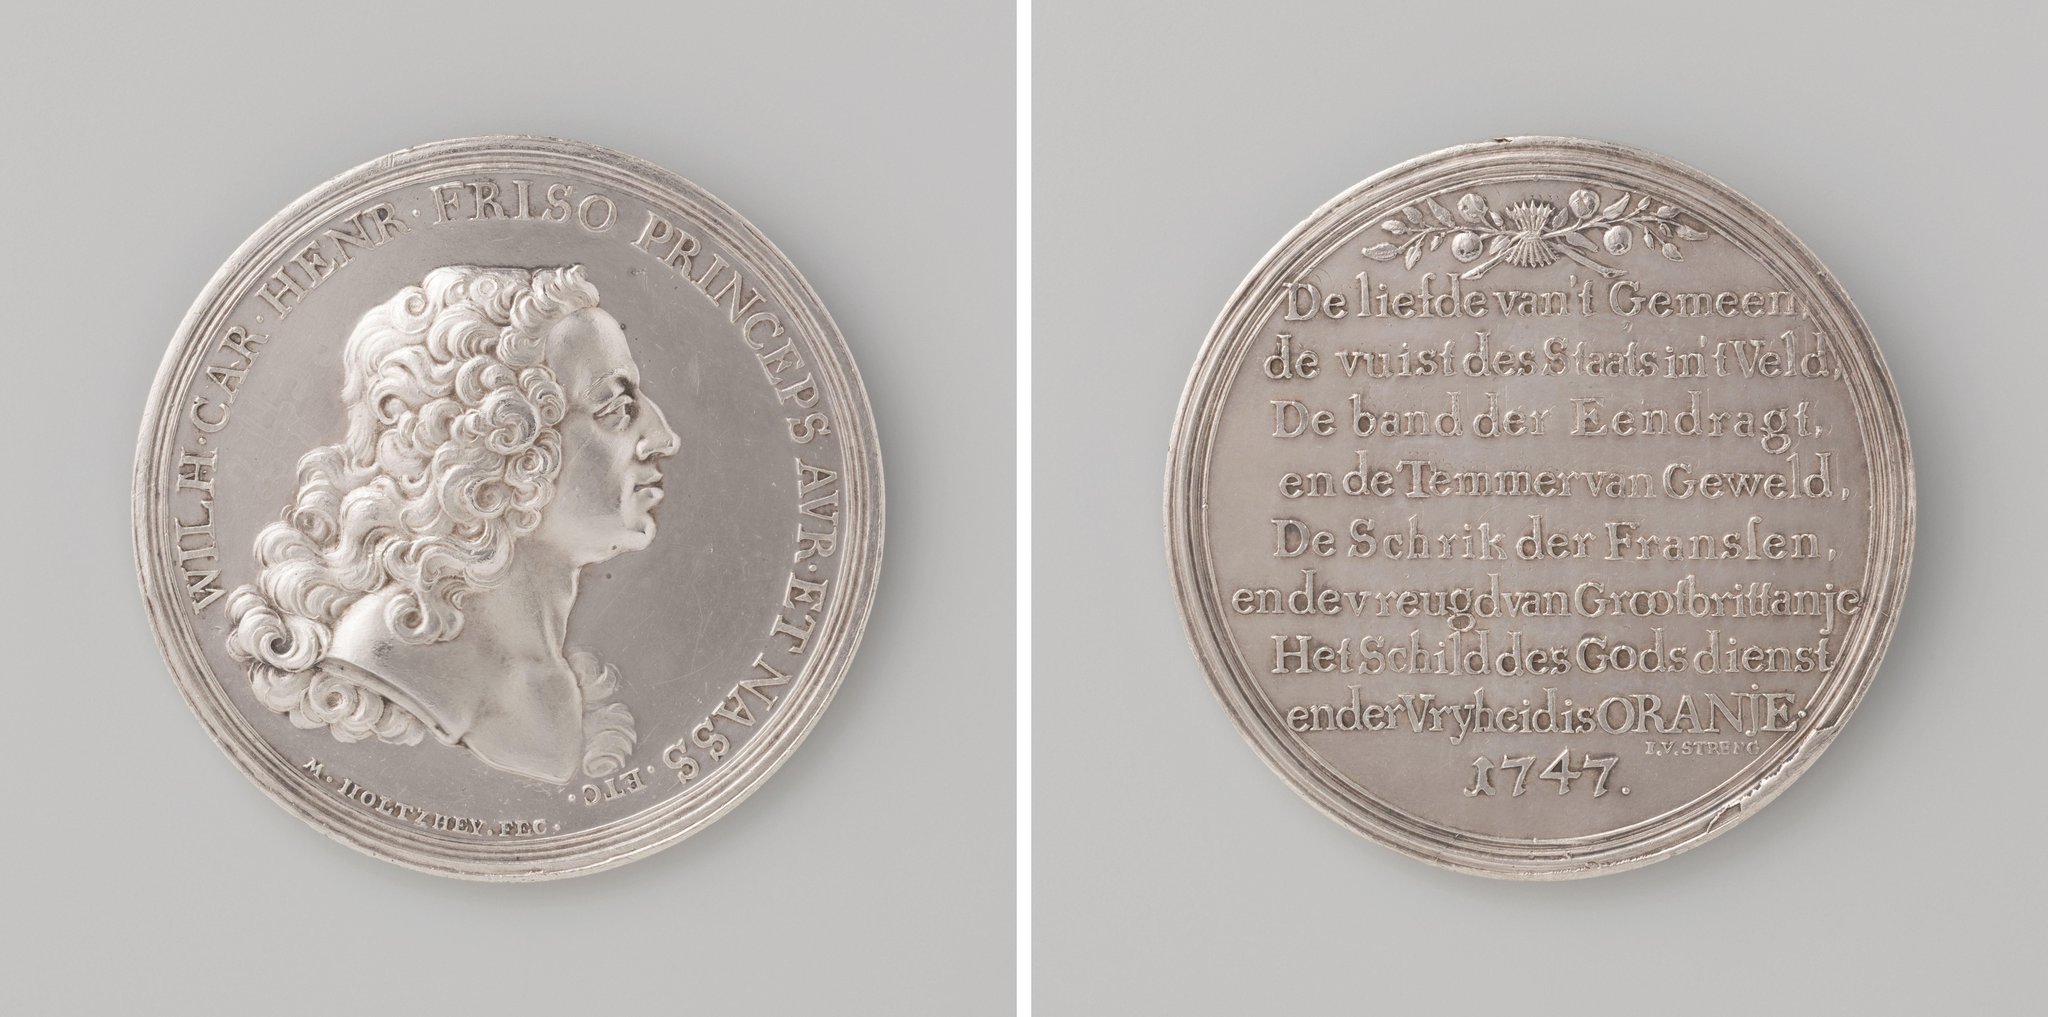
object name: history medal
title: Verheffing van de prins van Oranje tot stadhouder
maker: martinus holtzhey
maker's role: medailleur, muntmaker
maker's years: 1697-1764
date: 1747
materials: silver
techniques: striking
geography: amsterdam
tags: the hague, willem iv (prins van oranje-nassau)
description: Zilveren penning. Voorzijde: borststuk man binnen omschrift. Keerzijde: opschrift onder twee gekruiste oranjetakken met pijlenbundel